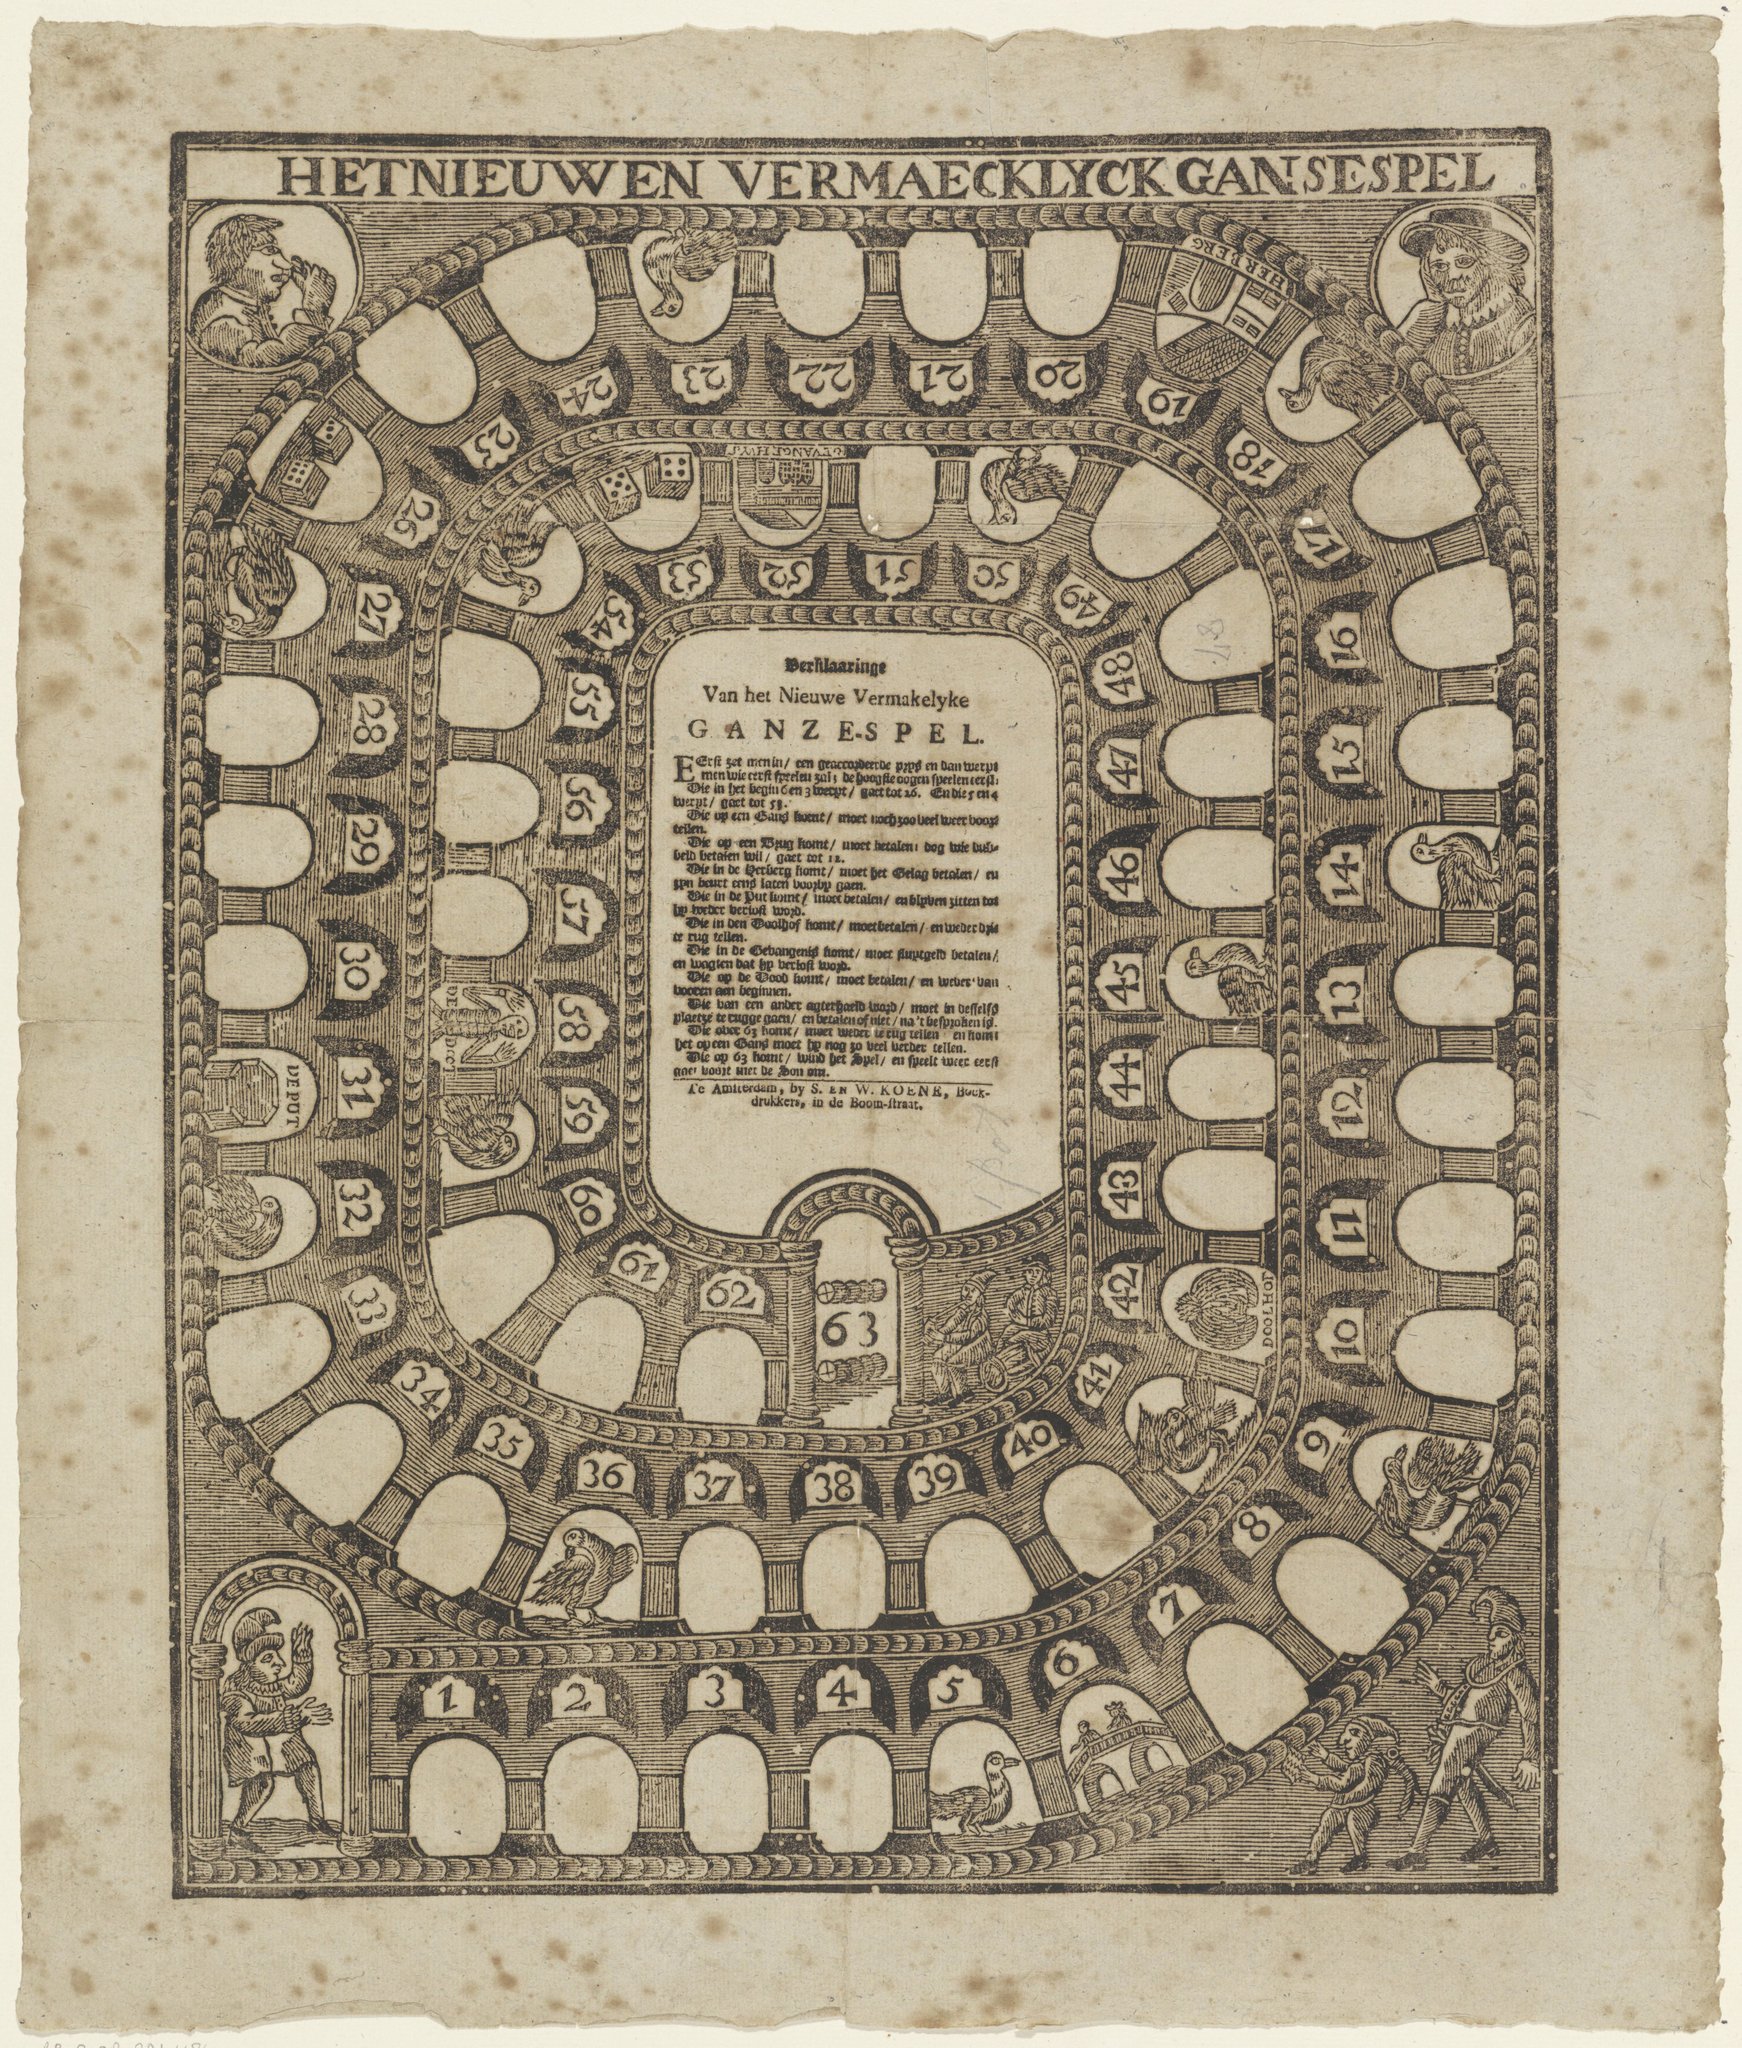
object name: game of goose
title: Het nieuw en vermaeckelyck gansespel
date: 1800-1810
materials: paper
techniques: letterpress printing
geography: amsterdam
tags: goose-game, board-games of chance, board-games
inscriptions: collector's mark: Lugt 2760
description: Ganzenbordspel met vakjes genummerd van 1 tot en met 63. In enkele vakjes voorstellingen van ganzen. In het grote centrale vak de spelregels. Titel in de bovenmarge.